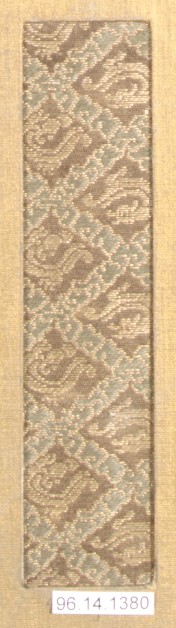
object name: piece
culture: japanese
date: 1701-1900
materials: silk